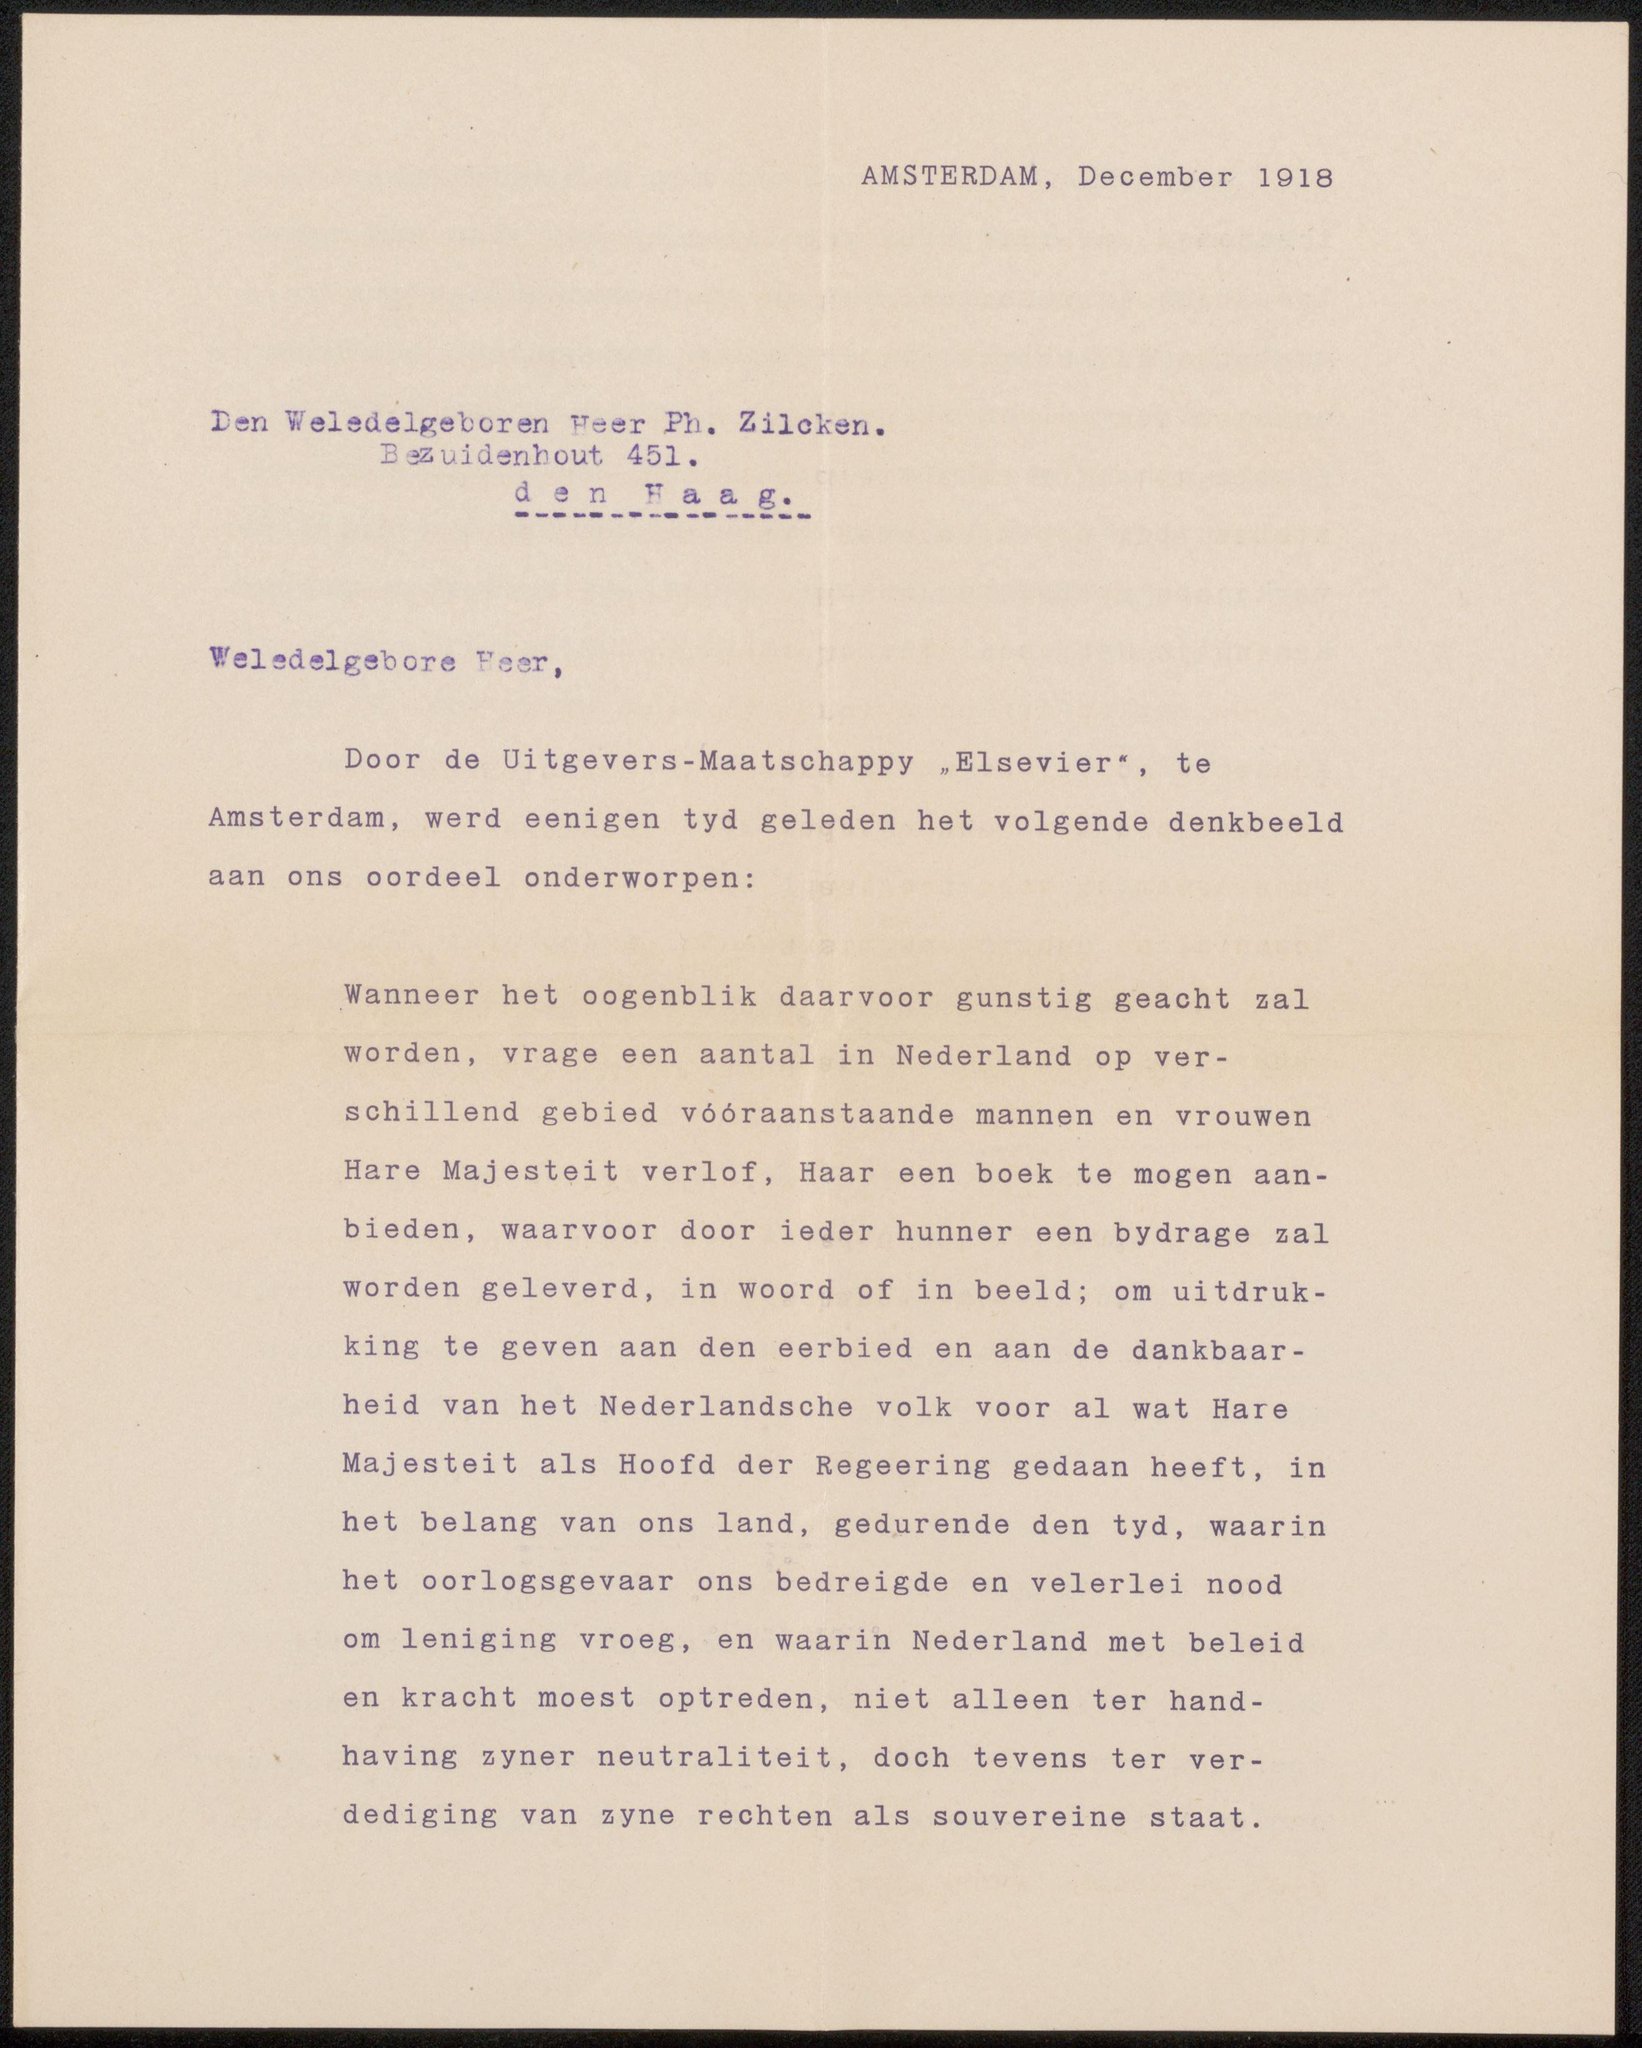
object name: letter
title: Brief aan Philip Zilcken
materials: paper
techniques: printing, typewriting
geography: amsterdam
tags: wilhelmina of the netherlands, the hague, painter, philip zilcken, drawing, painting (including book-illumination, miniature-painting), printed matter